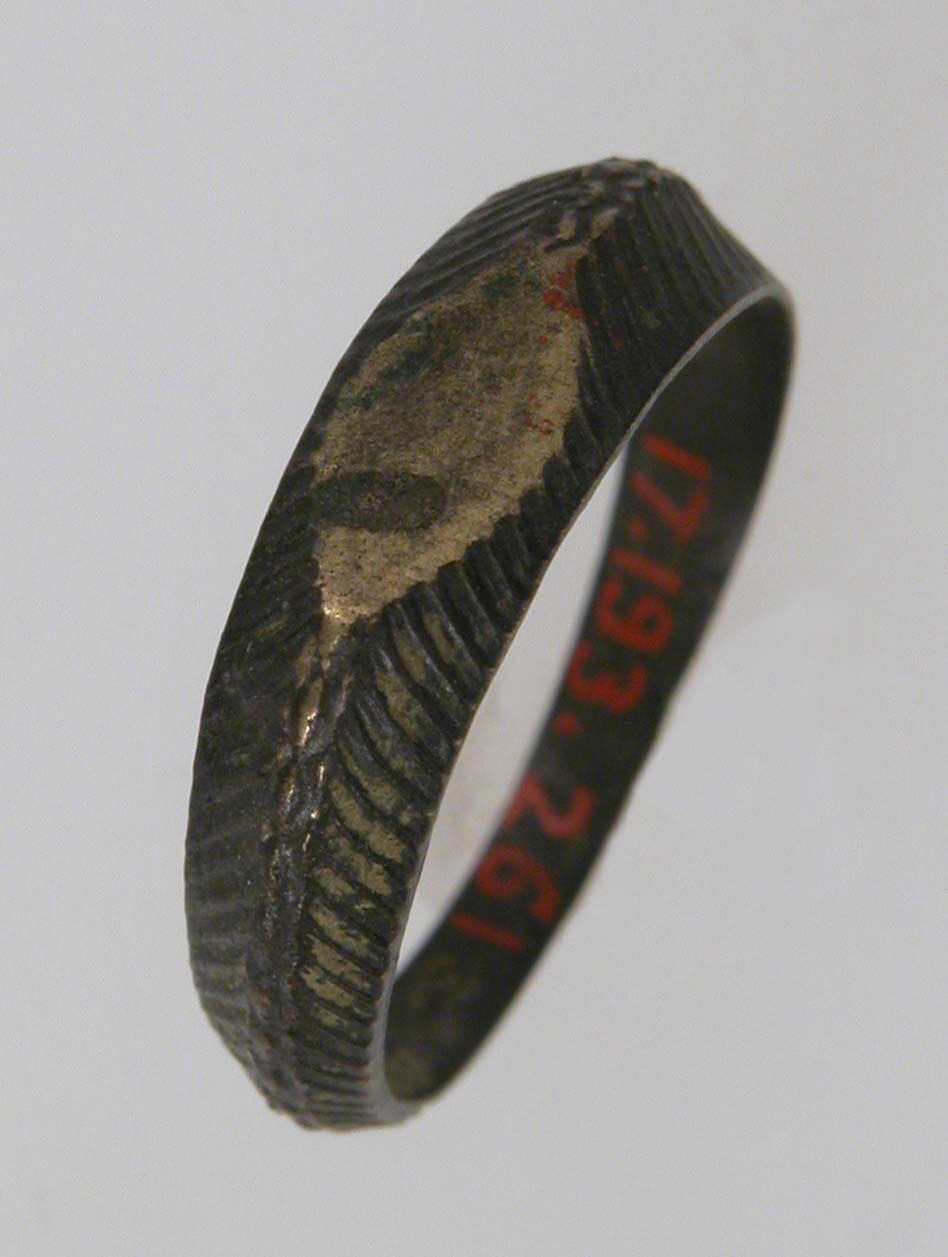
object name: ring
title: Finger Ring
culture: byzantine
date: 601-700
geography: germany